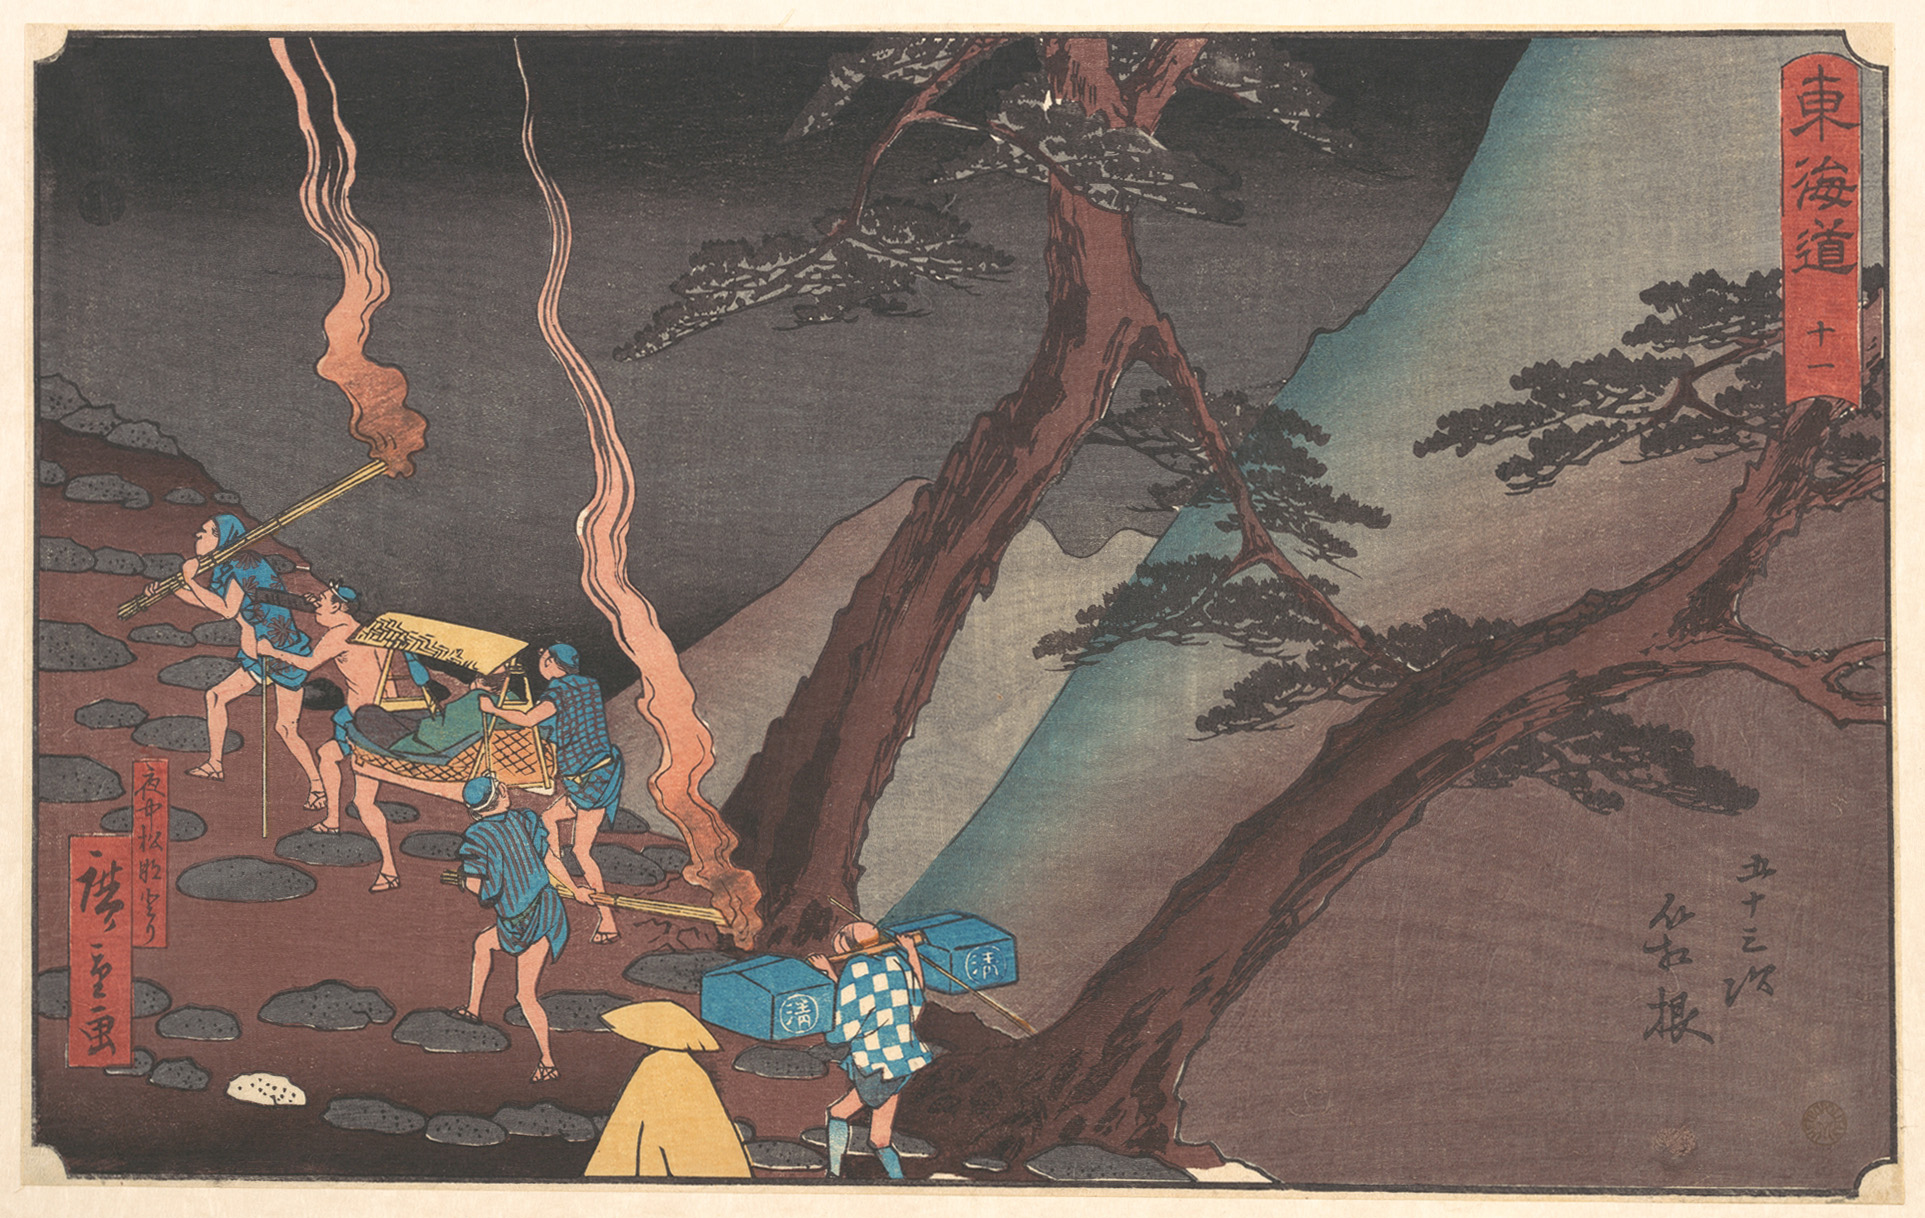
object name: print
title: Hakone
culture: japanese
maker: utagawa hiroshige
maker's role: artist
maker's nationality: japanese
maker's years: 1797-1858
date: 1848-1849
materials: ink, paper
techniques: woodblock print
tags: men,night